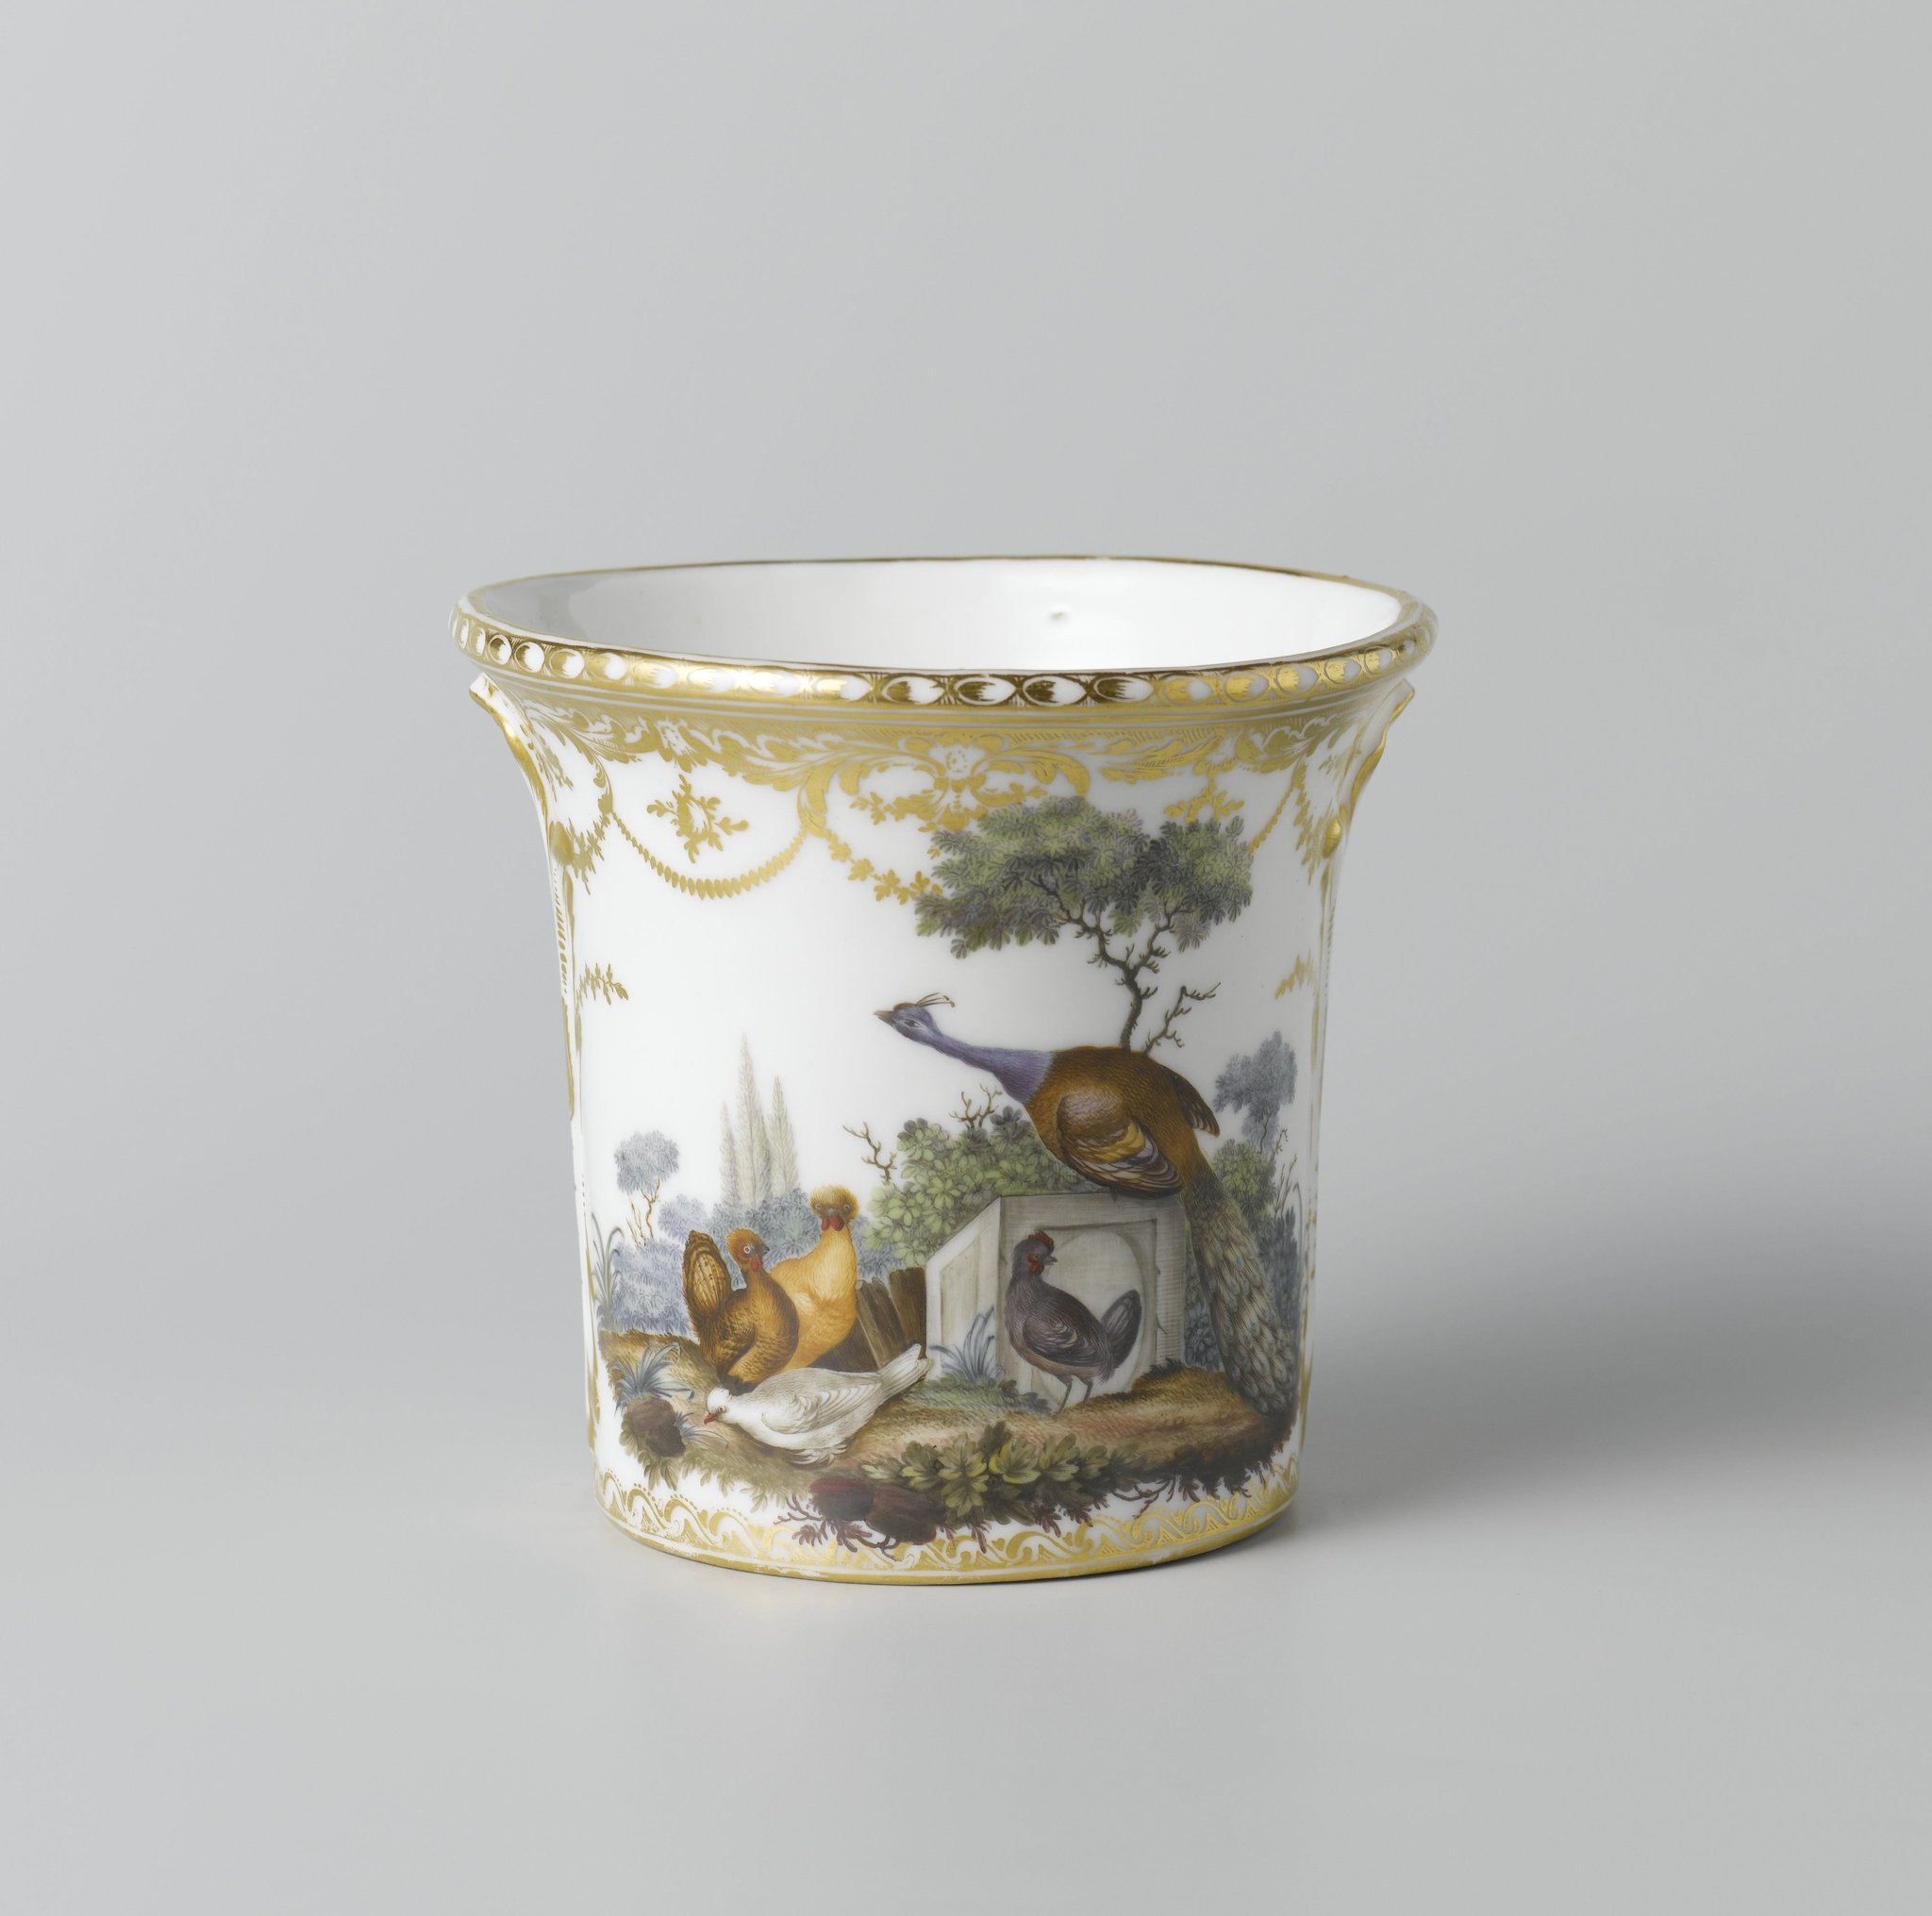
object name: cachepot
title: Three flowerpot containers (cache-pots) and stands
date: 1778-1782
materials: porcelain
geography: loosdrecht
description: Manufactuur Oud-Loosdrecht Loosdrecht, c. 1778–1782 hard-paste porcelain